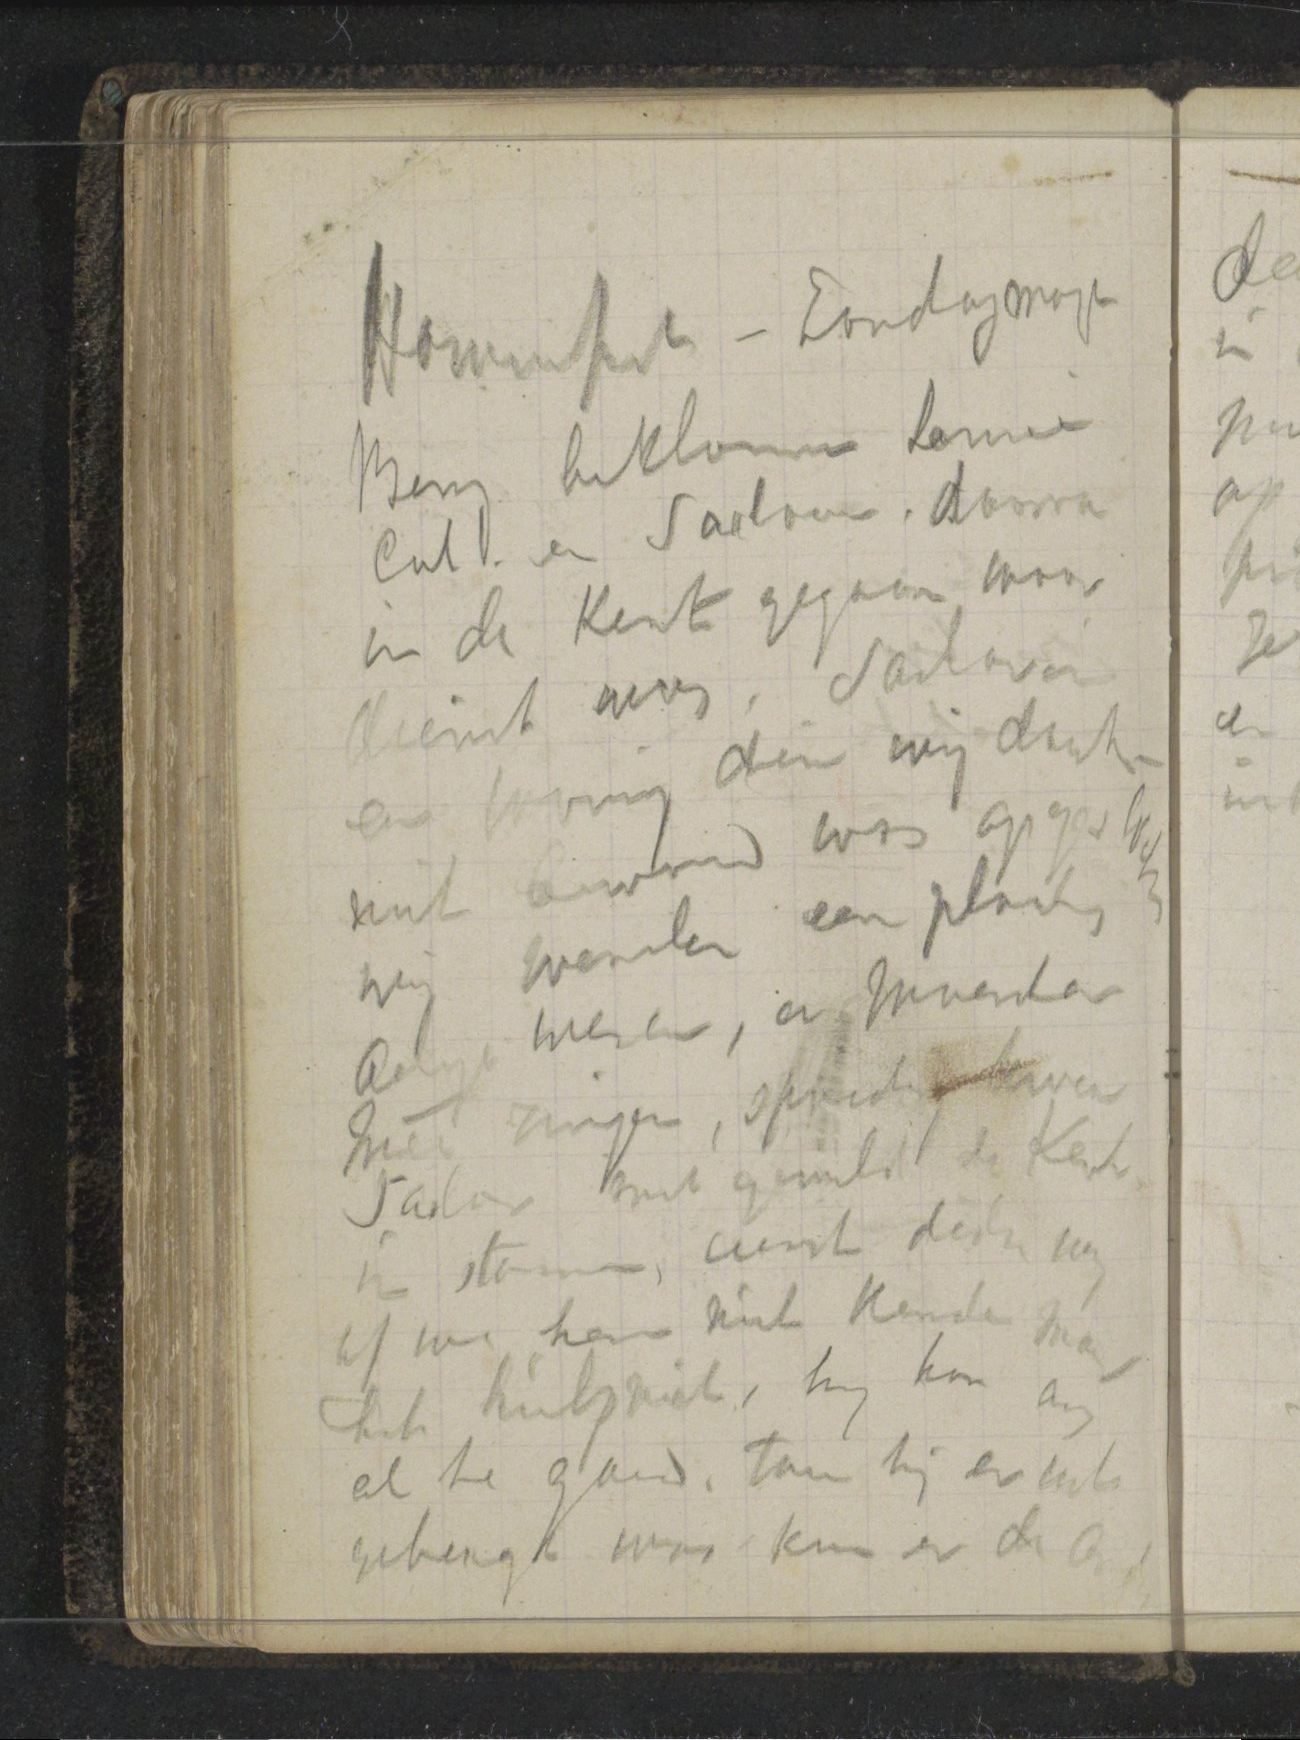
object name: sketchbook leaf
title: Reisverslag van begin september 1880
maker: louis apol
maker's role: draughtsman, painter, print maker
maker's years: 1850-1936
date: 1880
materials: pencil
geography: hammerfest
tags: hammerfest, nova zembla expedities 1880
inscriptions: annotation: ‘Hammerfest - Zondagmorgen / Berg beklommen Lowie / Cal. en Sailor, daarna / in de kerk gegaan waar / dienst was [...]’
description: Blad 45 verso uit een schetsboek met 110 bladen betekend tijdens de expeditie naar Nova Zembla in 1880.